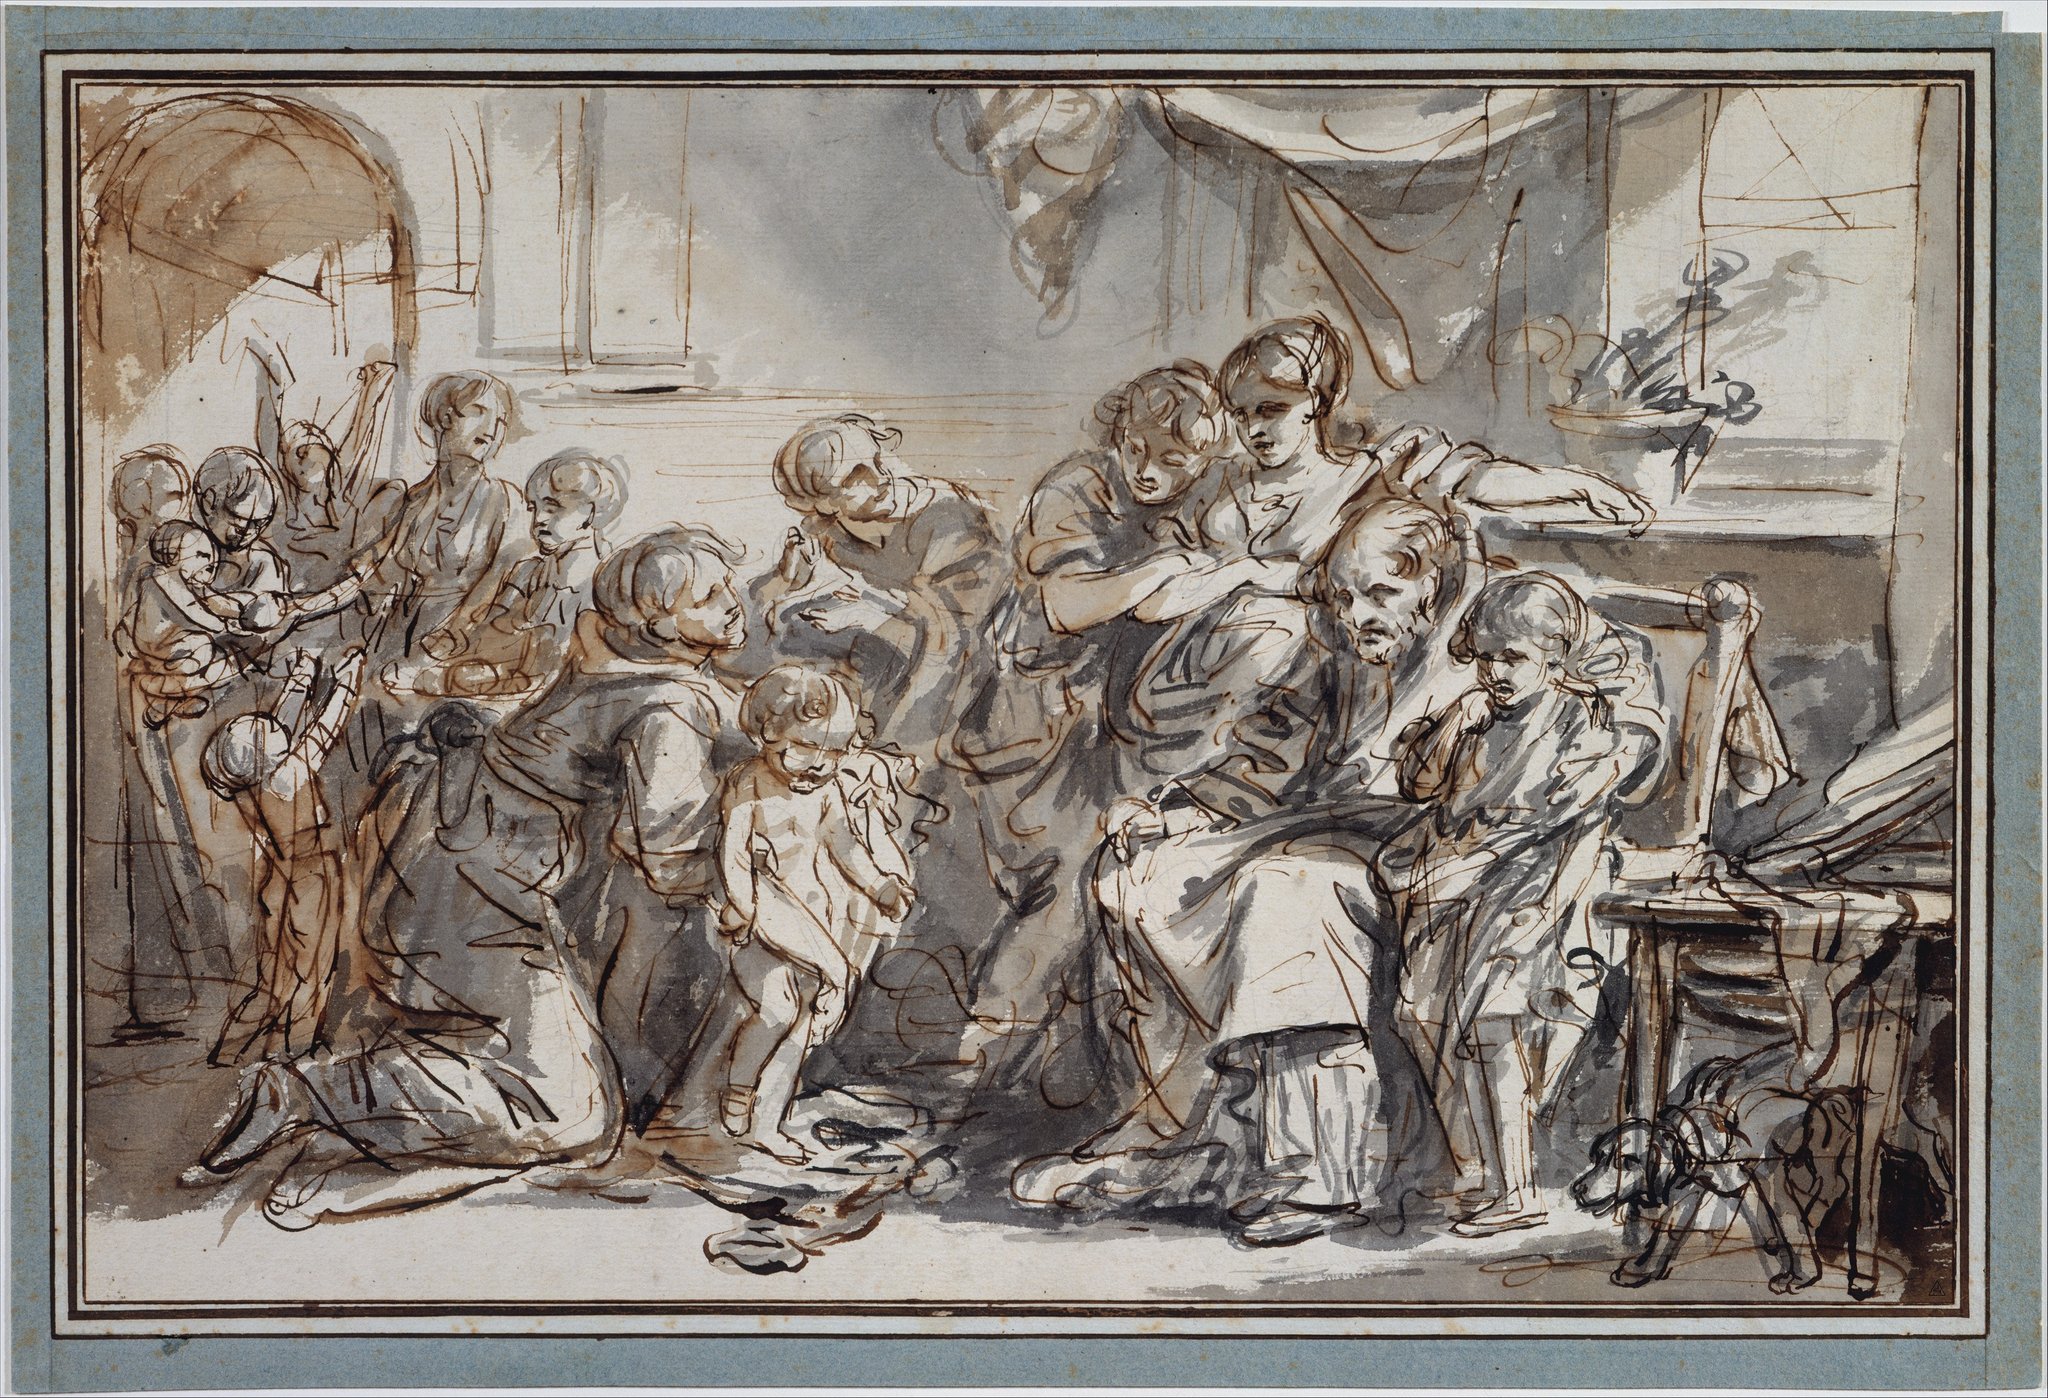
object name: drawing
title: Domestic Scene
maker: jean-baptiste greuze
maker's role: artist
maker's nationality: french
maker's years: 1725-1805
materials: chalk, ink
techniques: brush, pen, wash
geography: france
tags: children,men,women